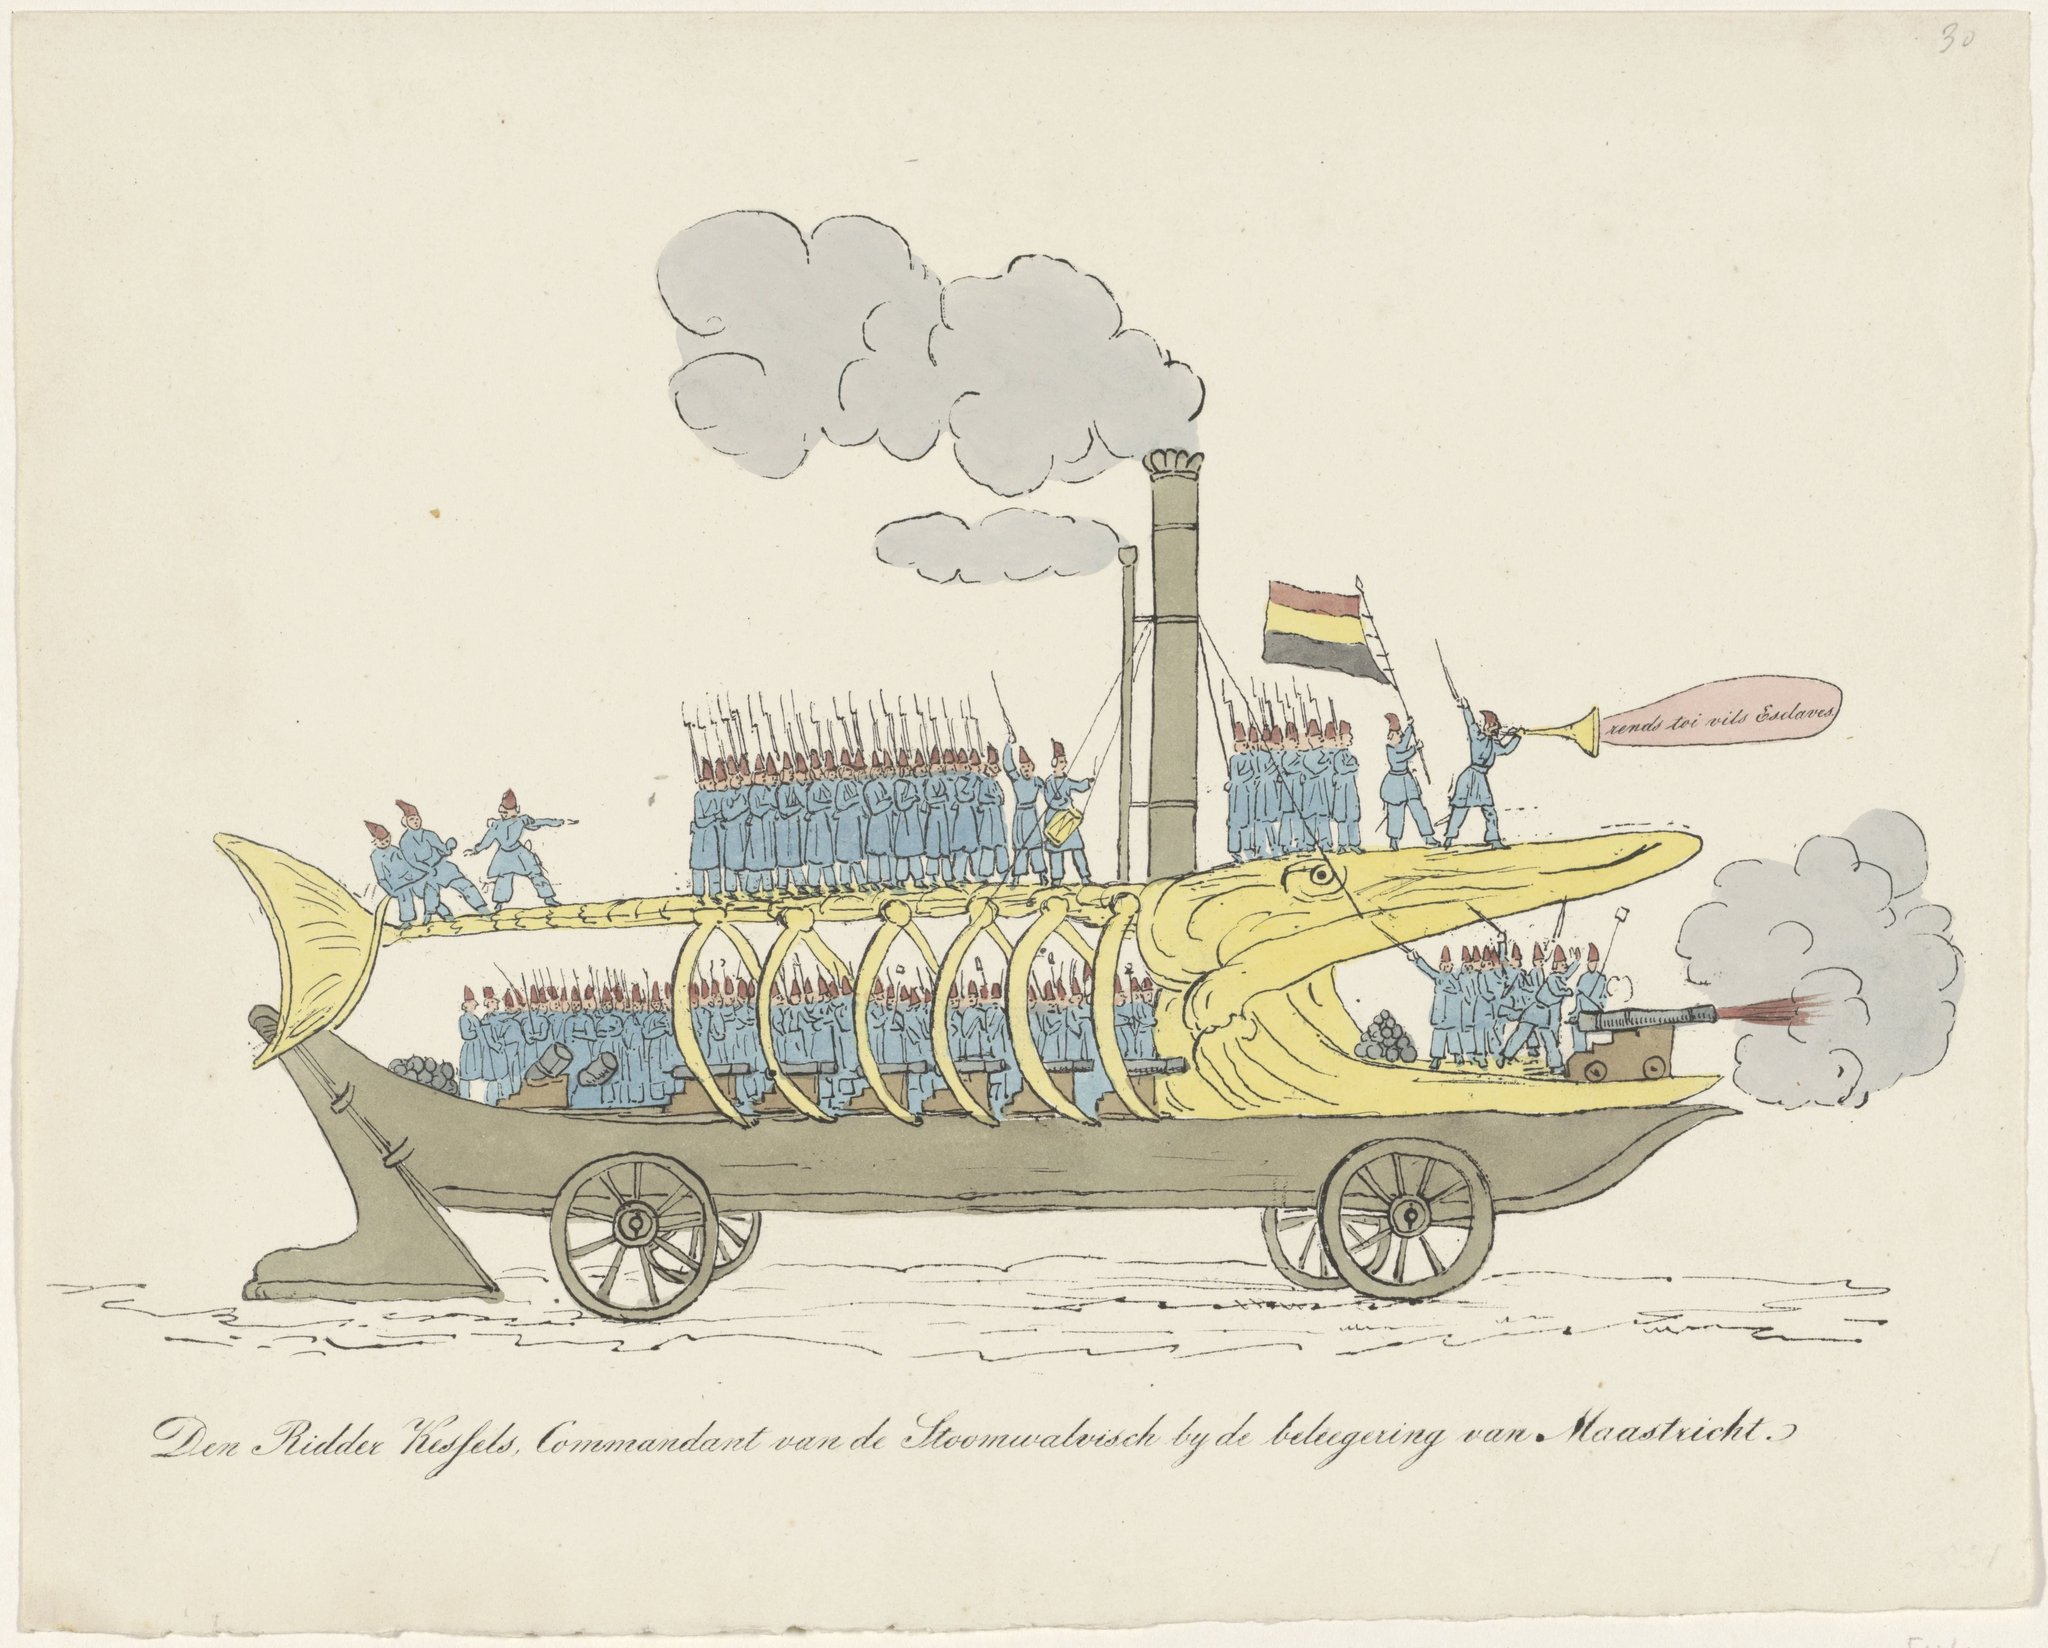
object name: cartoon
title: Den Ridder Kessels, Commandant van de Stoomwalvisch bij de beleegering van Maastricht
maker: Anonymous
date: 1830-1831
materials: paper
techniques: hand coloring, lithograph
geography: netherlands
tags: herman kessels, swimming mammals: whale, maastricht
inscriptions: collector's mark: Lugt 2228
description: Spotprent op generaal Herman Kessels en zijn geraamte van een walvis, 1830-1831. De walvisgeraamte is voorzien van wielen en een stoommachine en bemand door Belgische opstandelingen. Vanuit de mond wordt een kanon afgevuurd. De titel verwijst naar de Belgische belegering van Maastricht in 1830-1831.